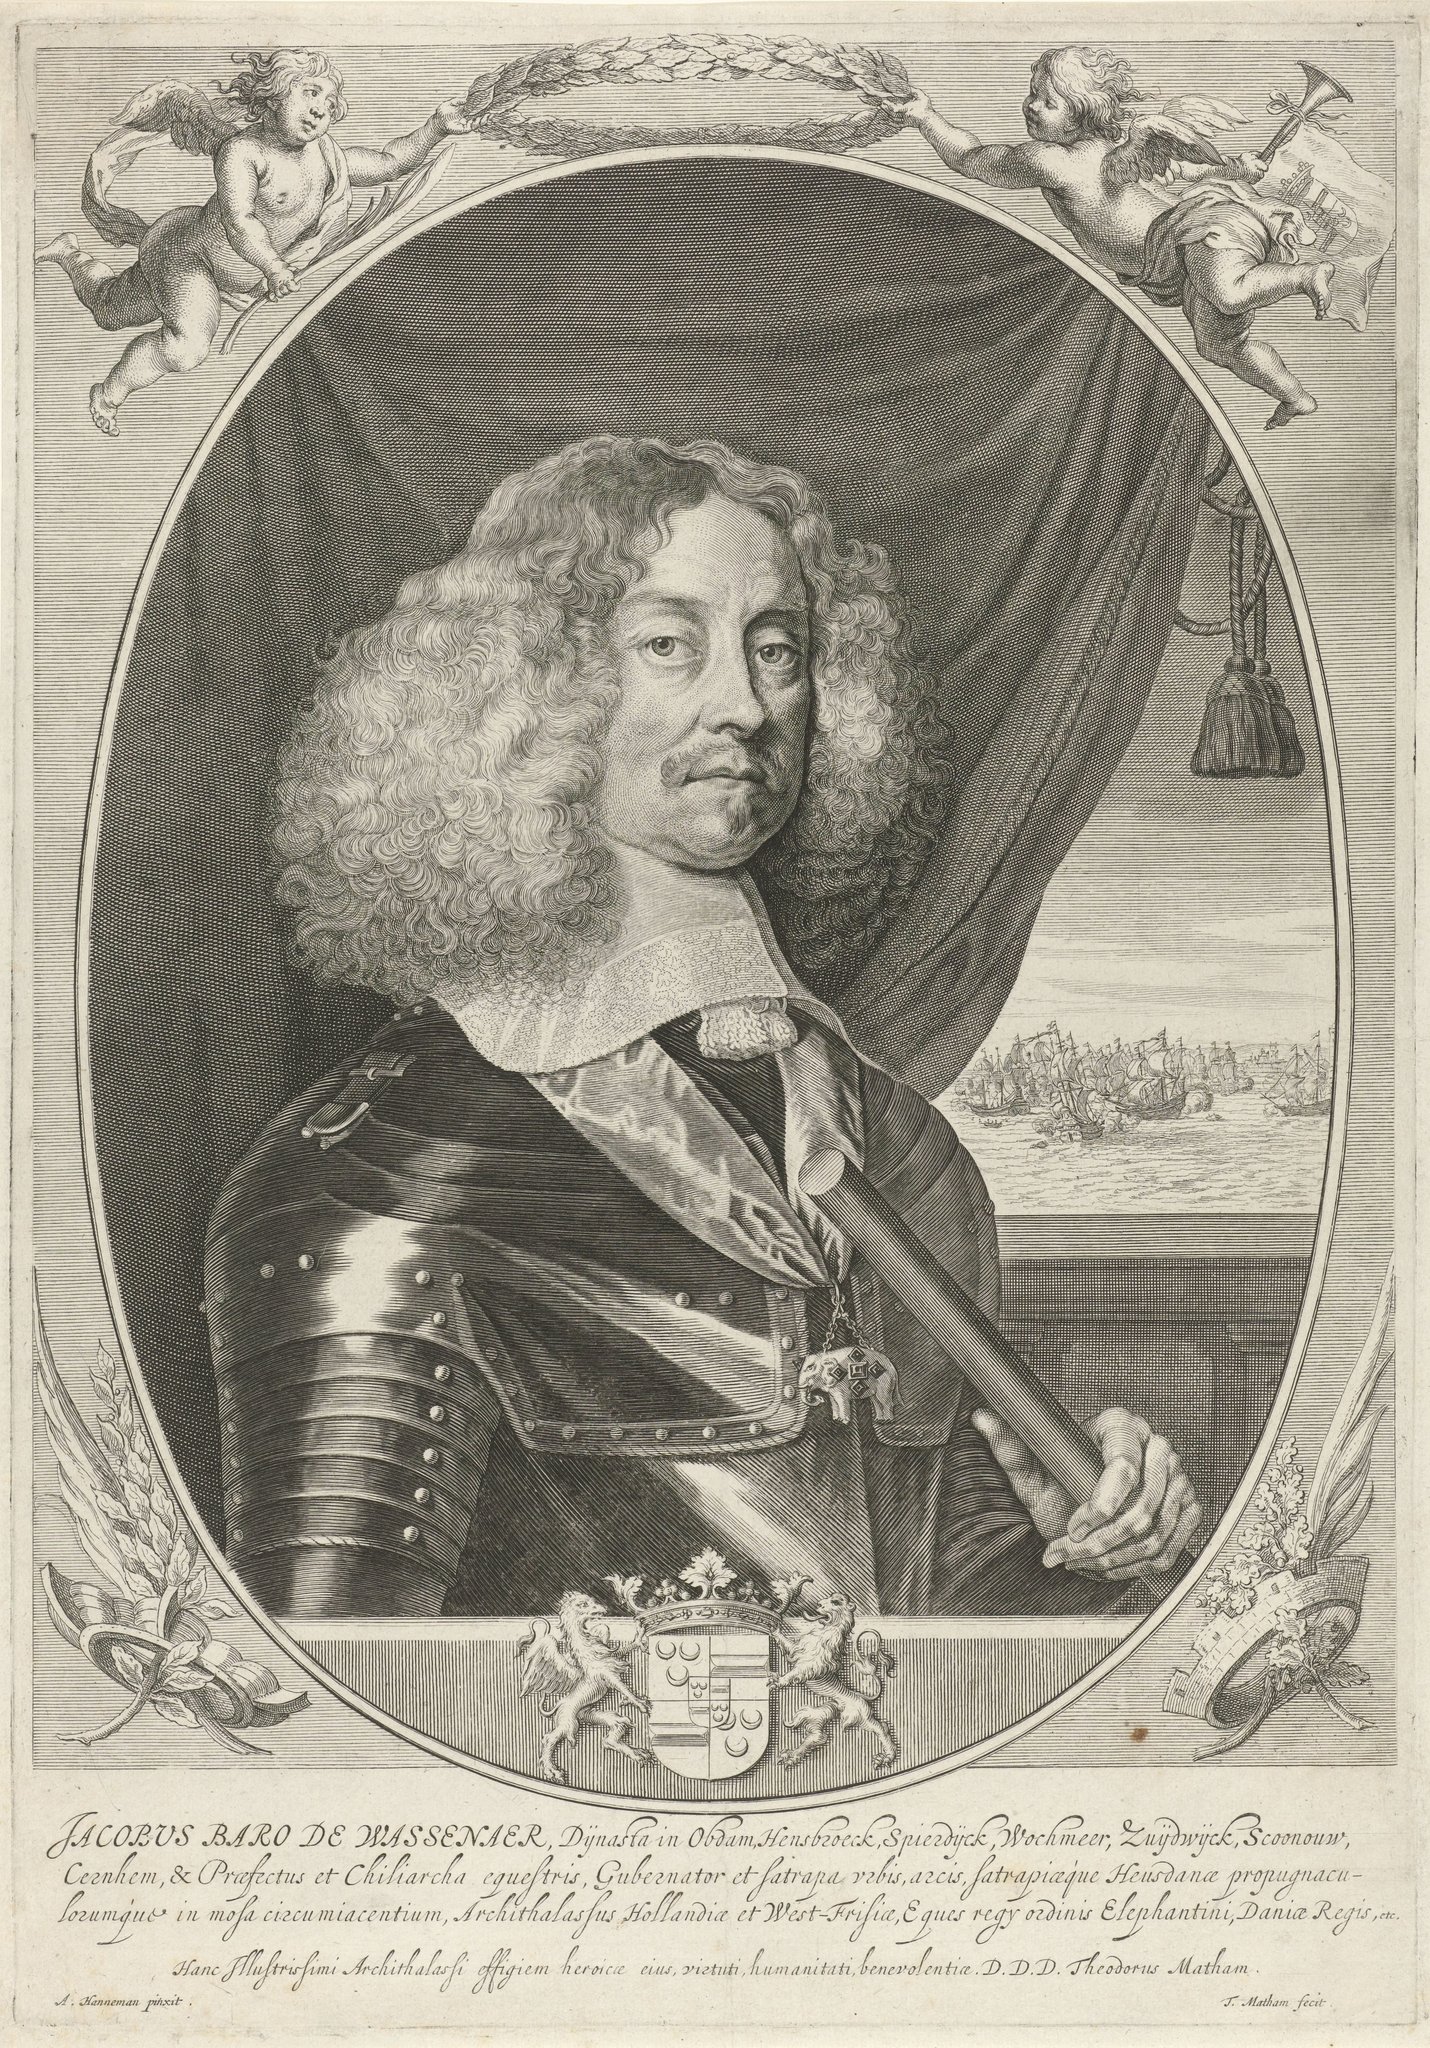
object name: print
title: Portret van Jacob baron van Wassenaer heer van Obdam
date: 1658-1676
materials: paper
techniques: engraving, etching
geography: northern netherlands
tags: jacob baron van wassenaer heer van obdam, knighthood order, baton of general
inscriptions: collector's mark: Lugt 2228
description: Portret van Jacob baron van Wassenaer heer van Obdam, als admiraal, met in zijn hand een commandostaf en om zijn hals het teken van de Deense Orde van de Olifant. Op de achtergrond zijn vloot. Middenonder zijn wapen. Bovenaan twee putti met een lauwerkrans.